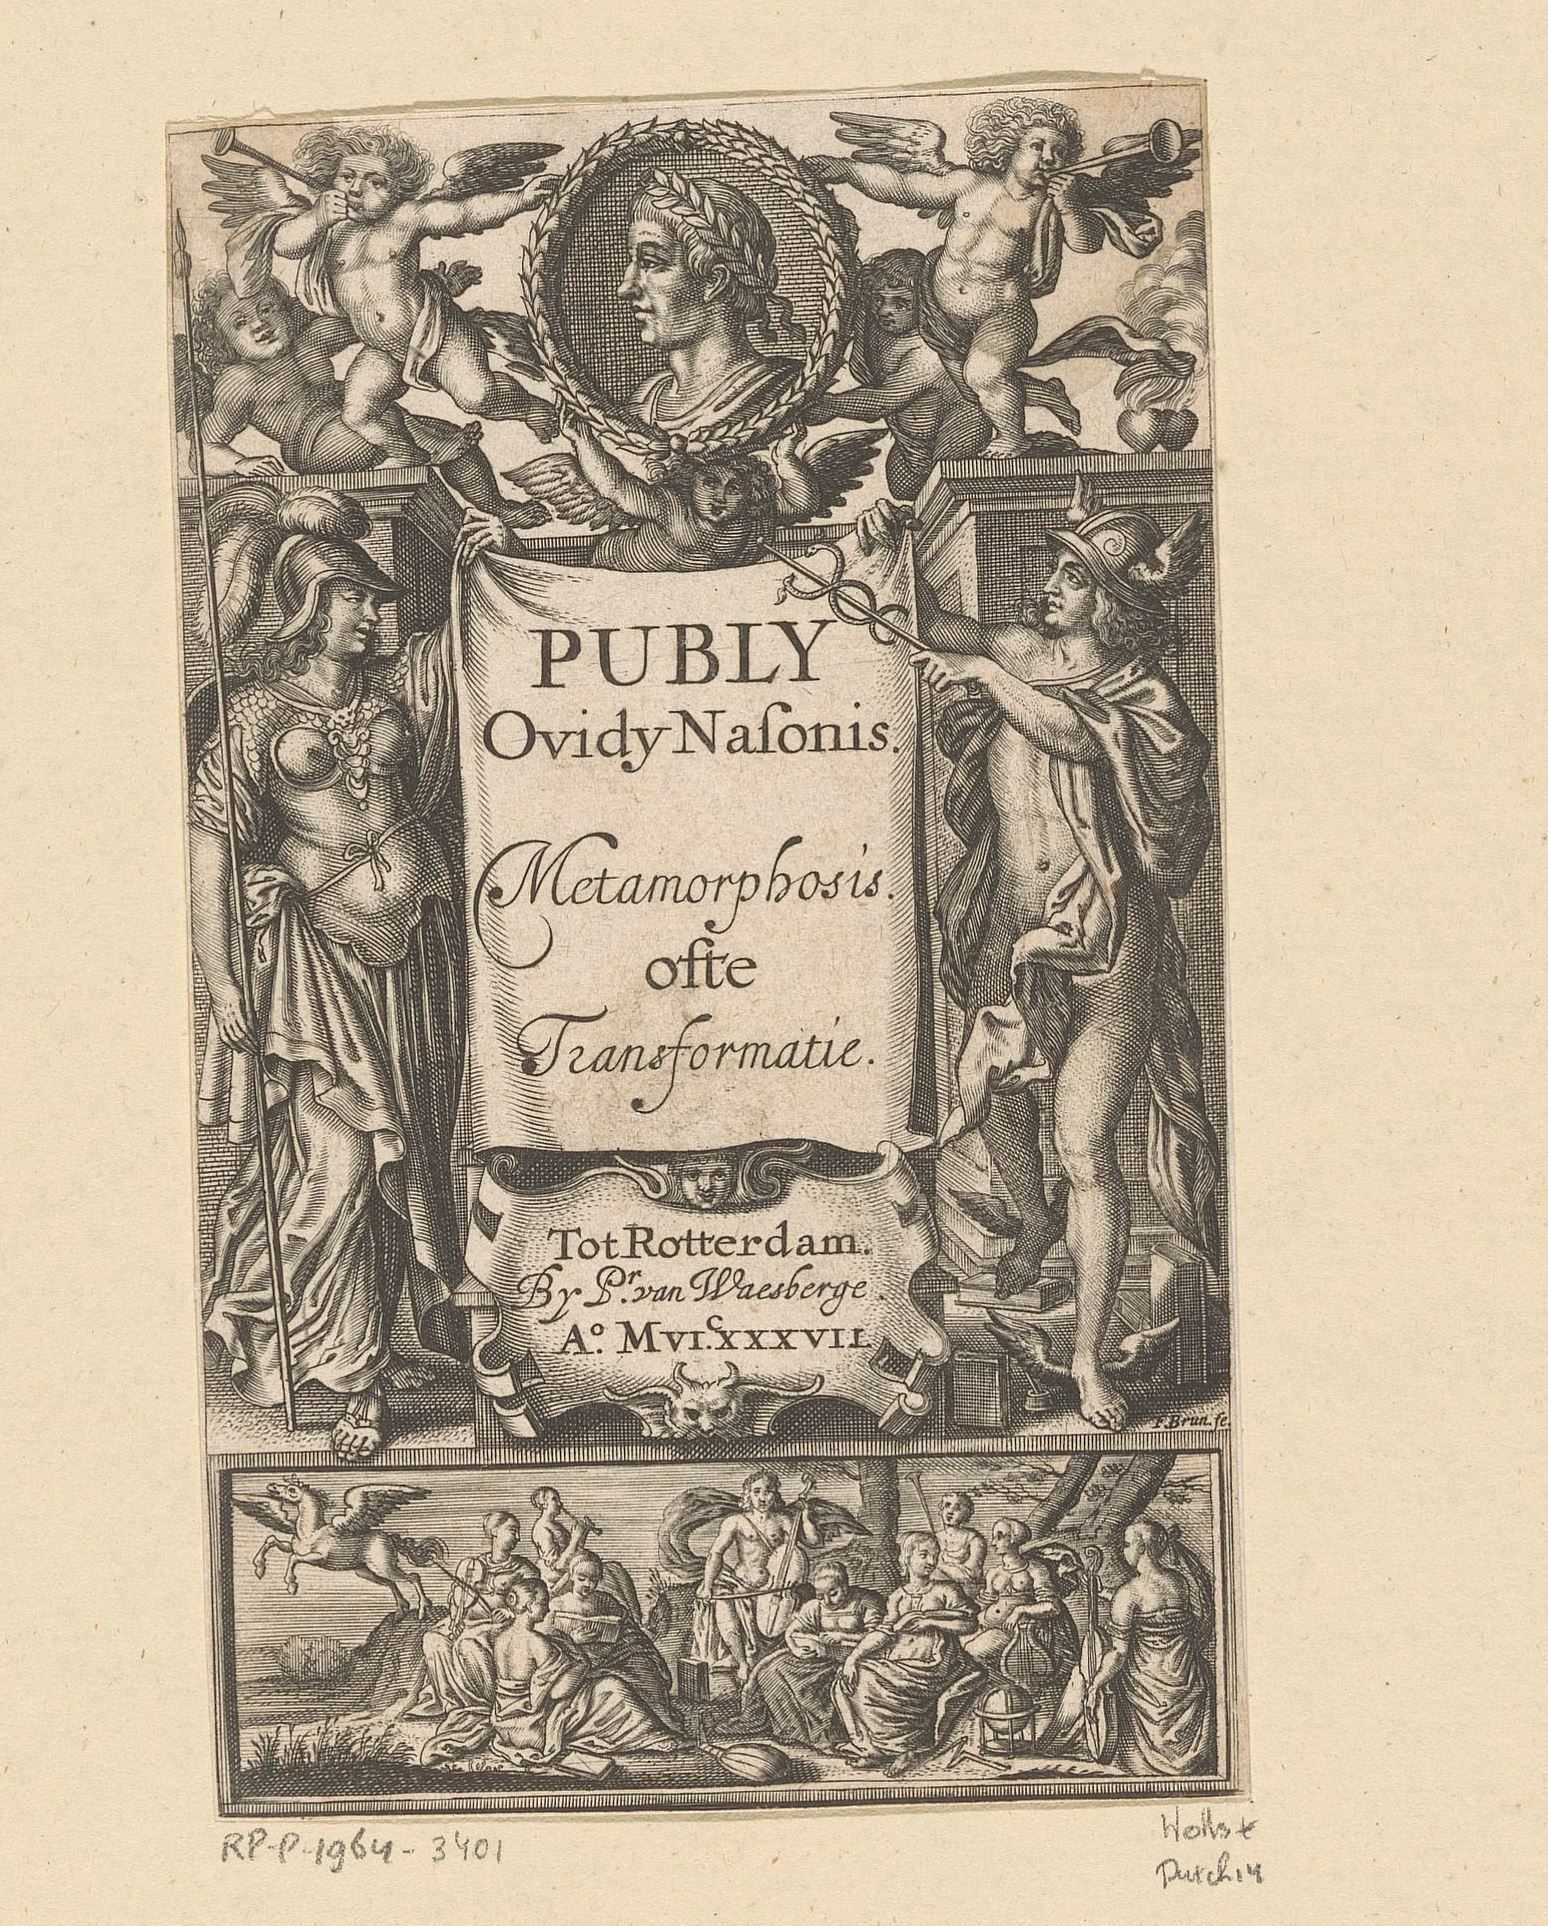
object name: print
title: Allegorische titelpagina met portret van Publius Ovidius Naso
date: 1637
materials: paper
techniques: engraving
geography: rotterdam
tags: publius ovidius naso, portrait of a writer, the muses acting together (as group), specific aspects, allegorical aspects of minerva; minerva as patroness, specific aspects, allegorical aspects of mercury; mercury as patron, cupids: 'amores', 'amoretti', 'putti'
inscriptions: date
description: Titelpagina voor: Publius Ovidius Naso, Metamorphosis, Dat is: De Herscheppinghe ofte Verânderinghe [in het Nederlands vertaald door:] Johannes Florianus. Rotterdam: Pieter van Waesberge, 1637.